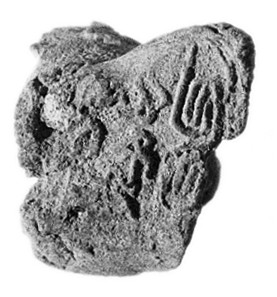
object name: sealing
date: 1981-1640 BCE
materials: mud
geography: egypt